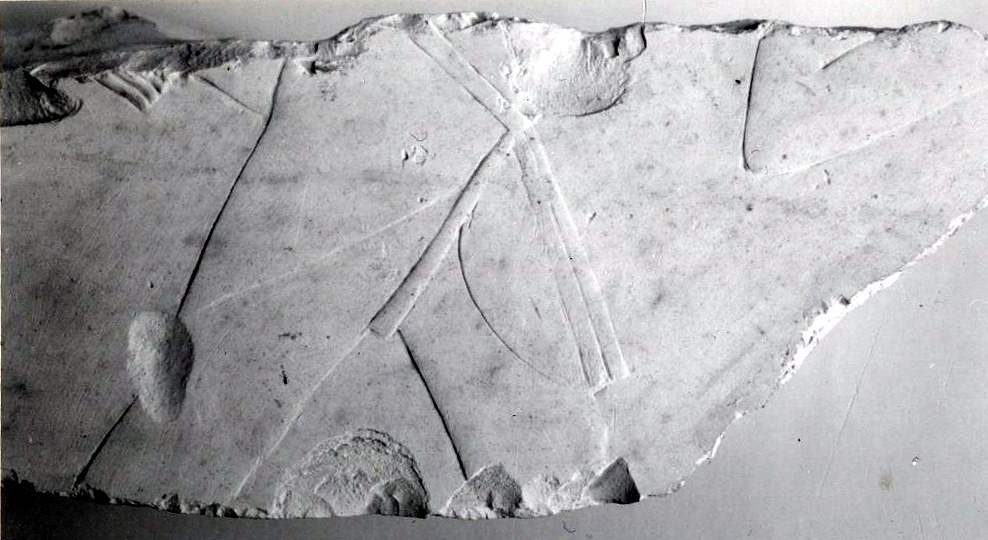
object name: relief fragment, tomb of meketre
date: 1981-1975 BCE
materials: limestone, paint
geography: egypt